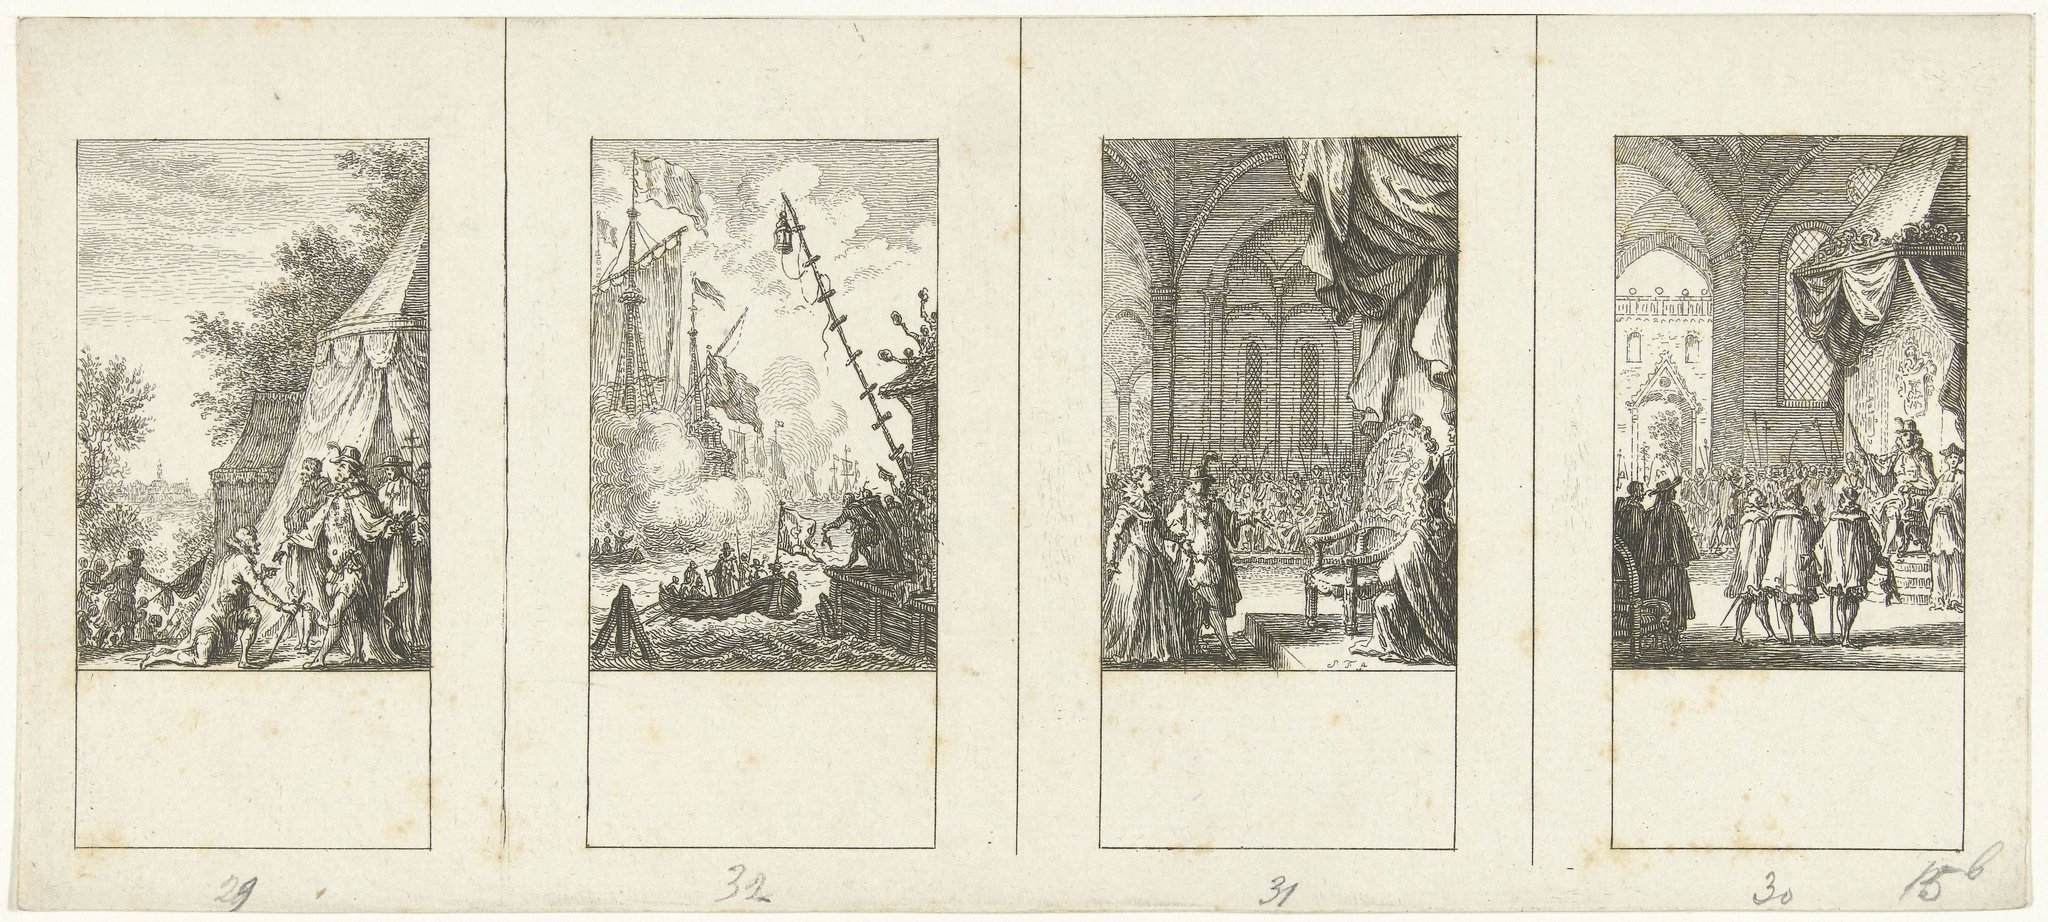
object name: print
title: Illustraties vaderlandse geschiedenis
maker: simon fokke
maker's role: draughtsman, print maker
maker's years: 1712-1784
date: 1722-1784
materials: paper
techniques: etching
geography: amsterdam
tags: philip ii of spain, ghent, charles v (holy roman emperor and king of spain), historical events and situations, historical persons (portraits and scenes from the life)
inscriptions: collector's mark: Lugt 2228, number: ‘29, 32, 31, 30’